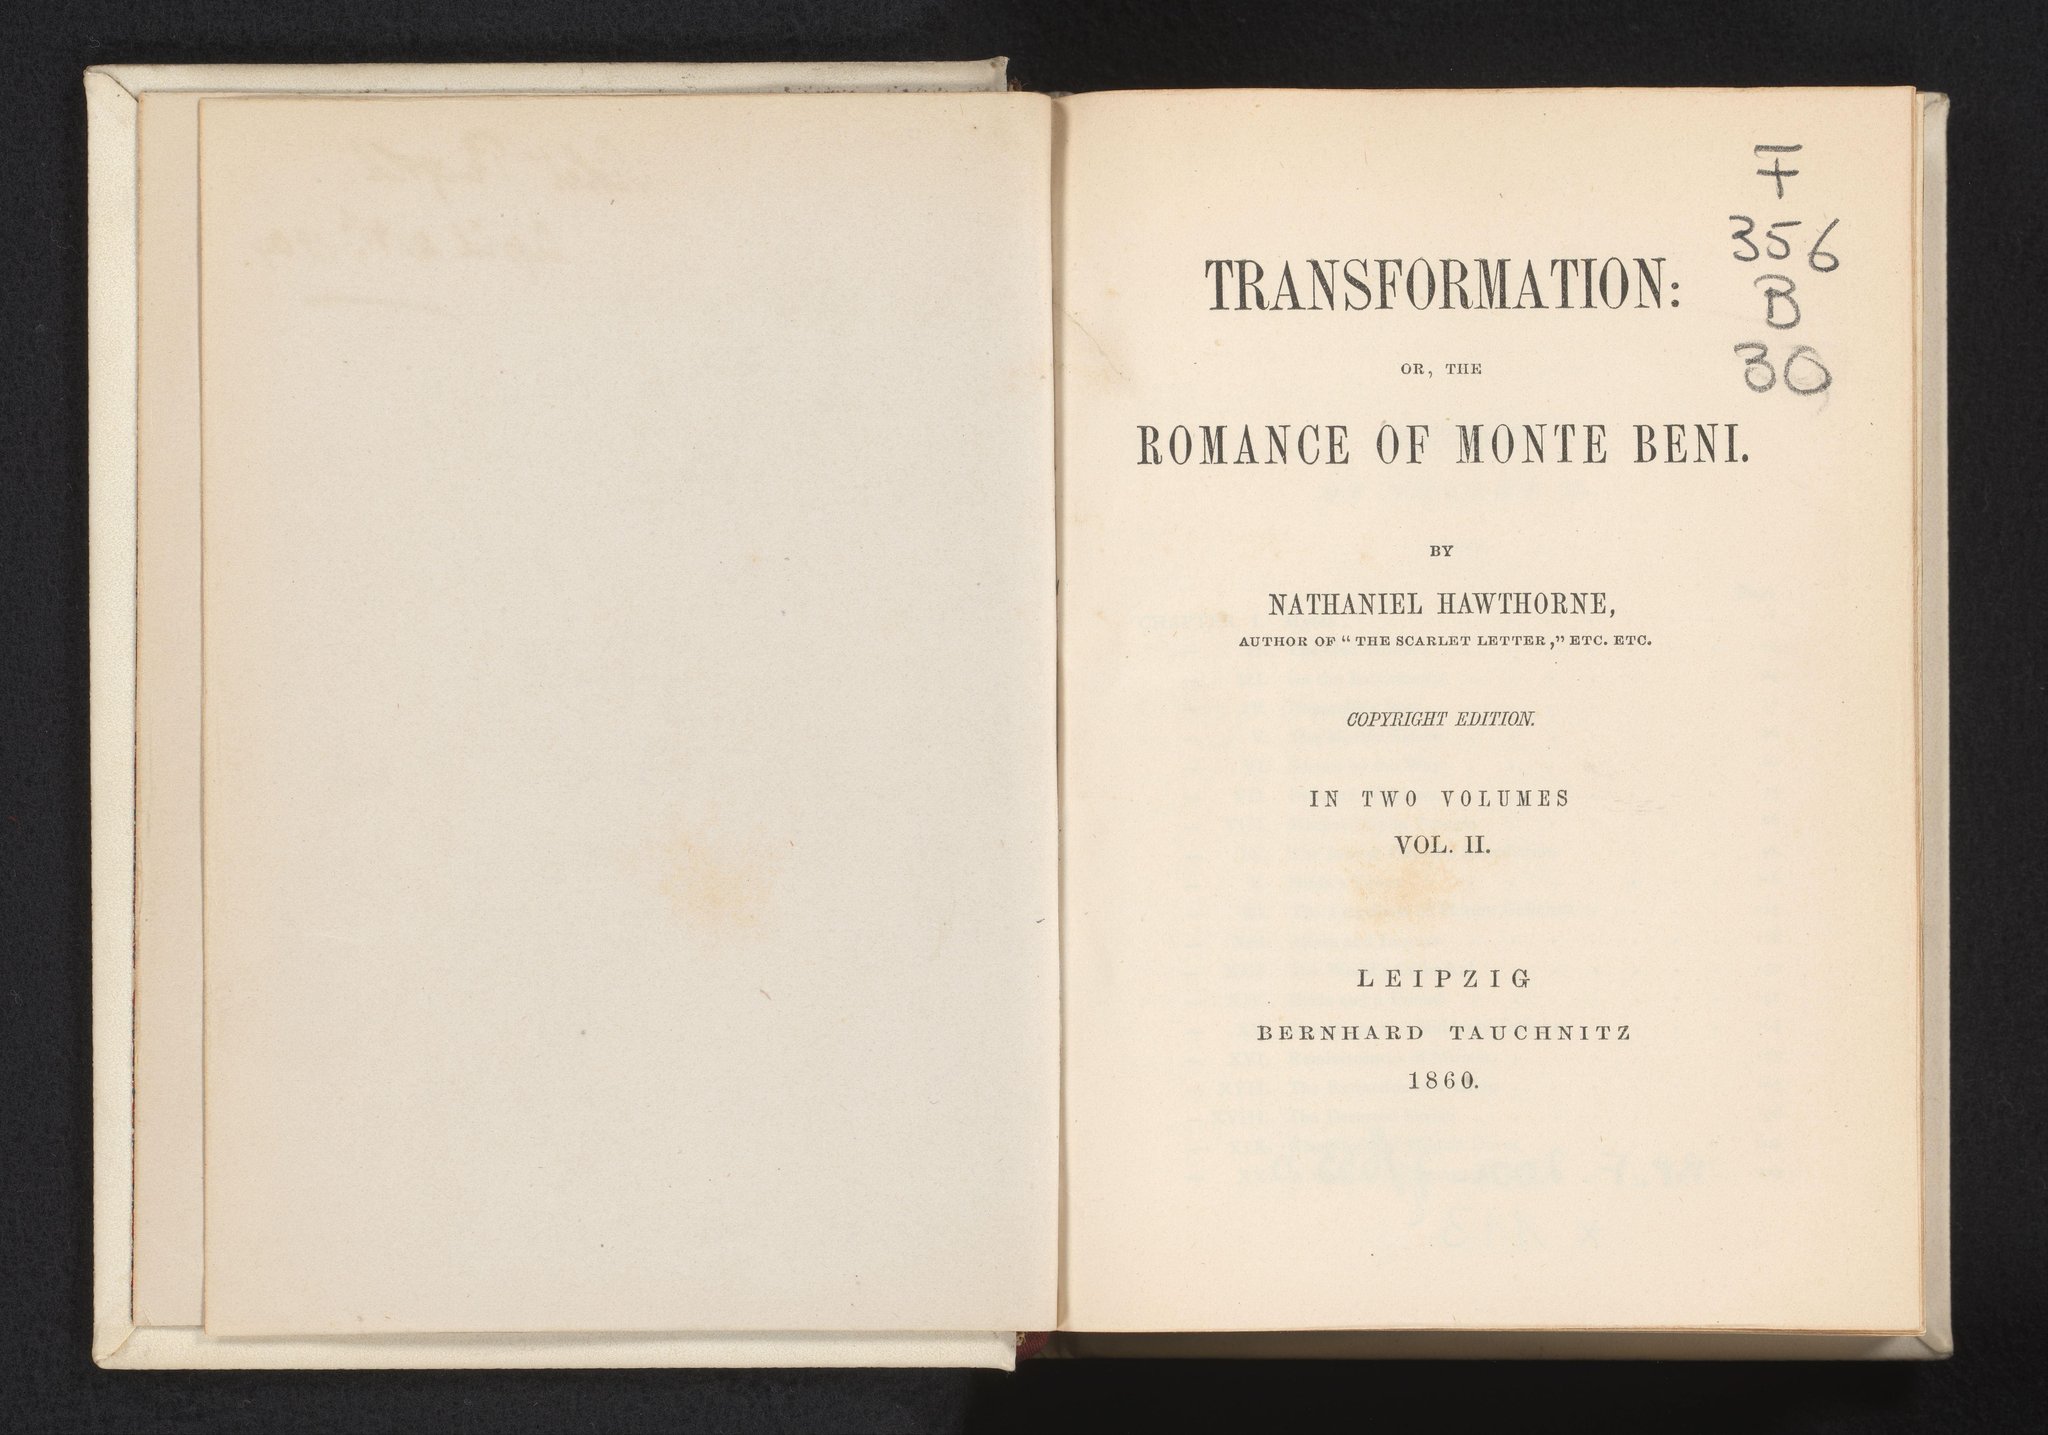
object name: book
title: Transformation : or, the romance of Monte Beni Vol. II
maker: bernhard tauchnitz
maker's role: publisher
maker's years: 1816-1895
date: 1860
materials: cardboard, paper, photographic support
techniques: albumen print, marbled paper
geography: leipzig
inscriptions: inscription: ‘Violet Panfold April 21st 1904.’